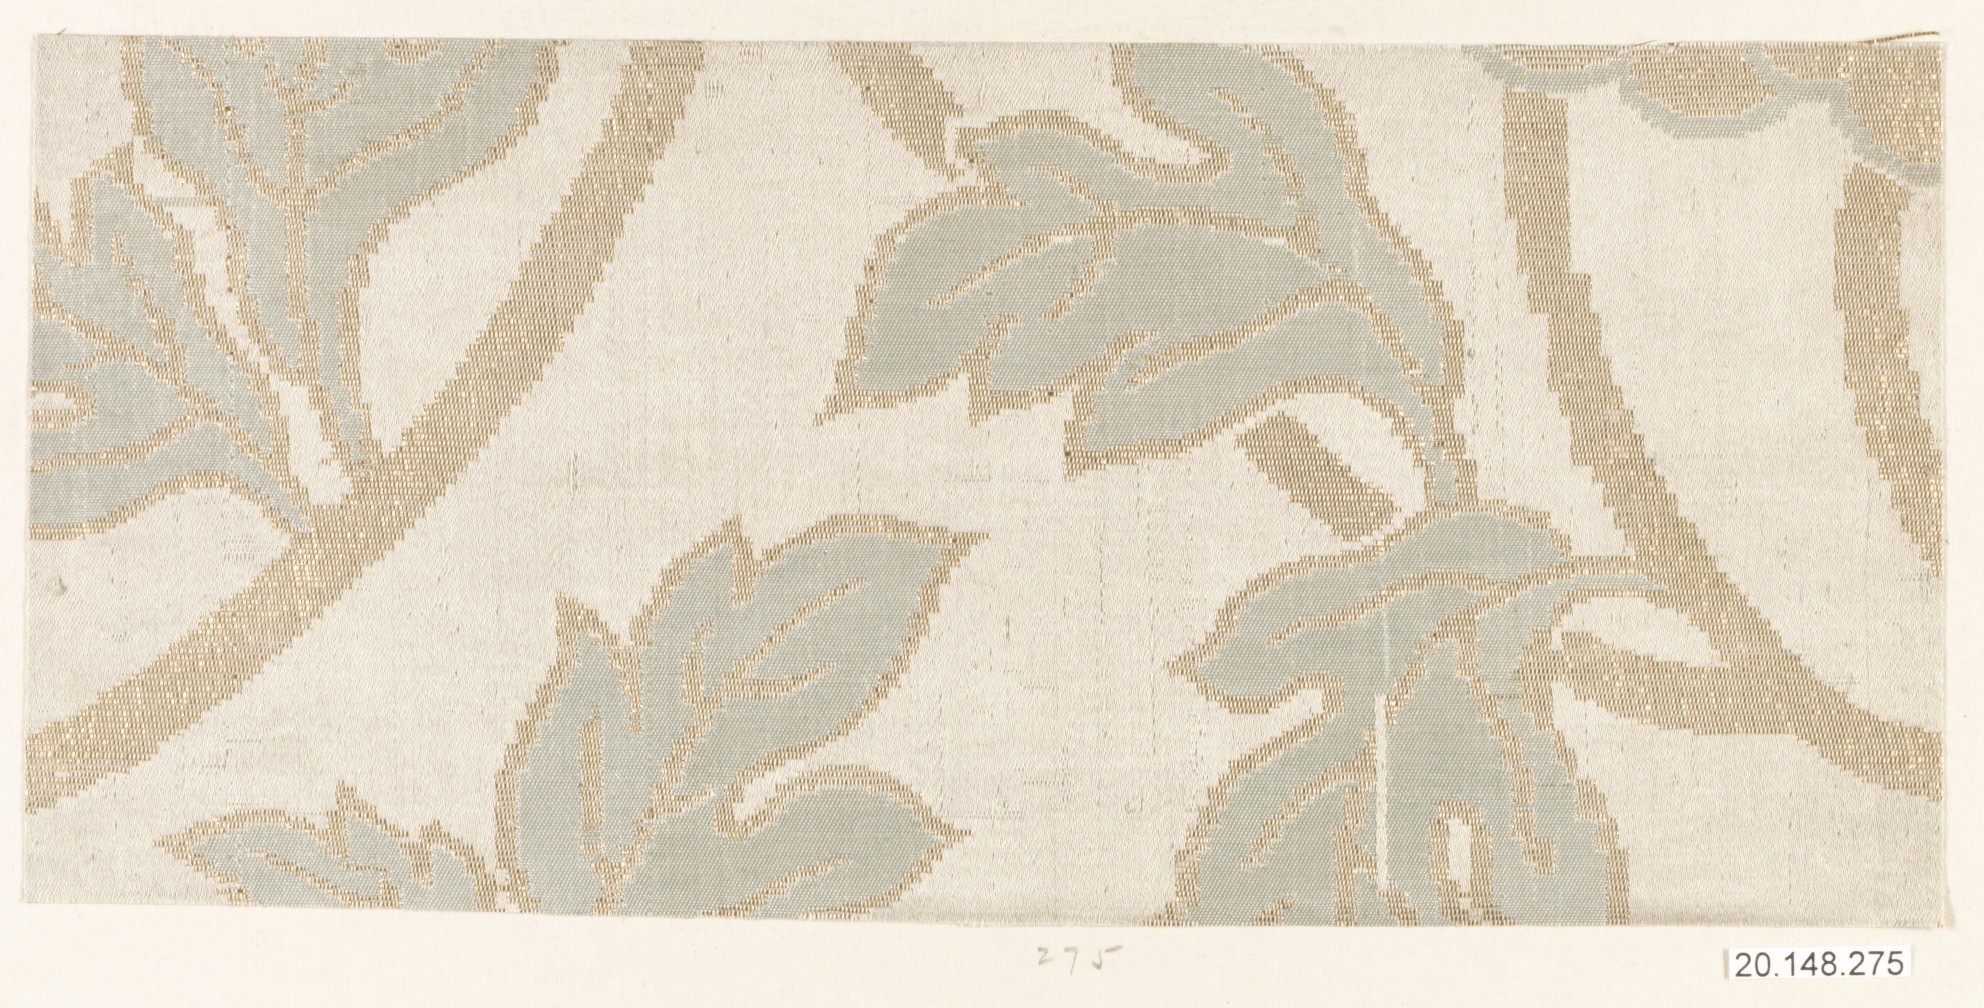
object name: piece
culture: japanese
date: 1701-1800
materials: silk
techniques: compound weave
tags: leaves